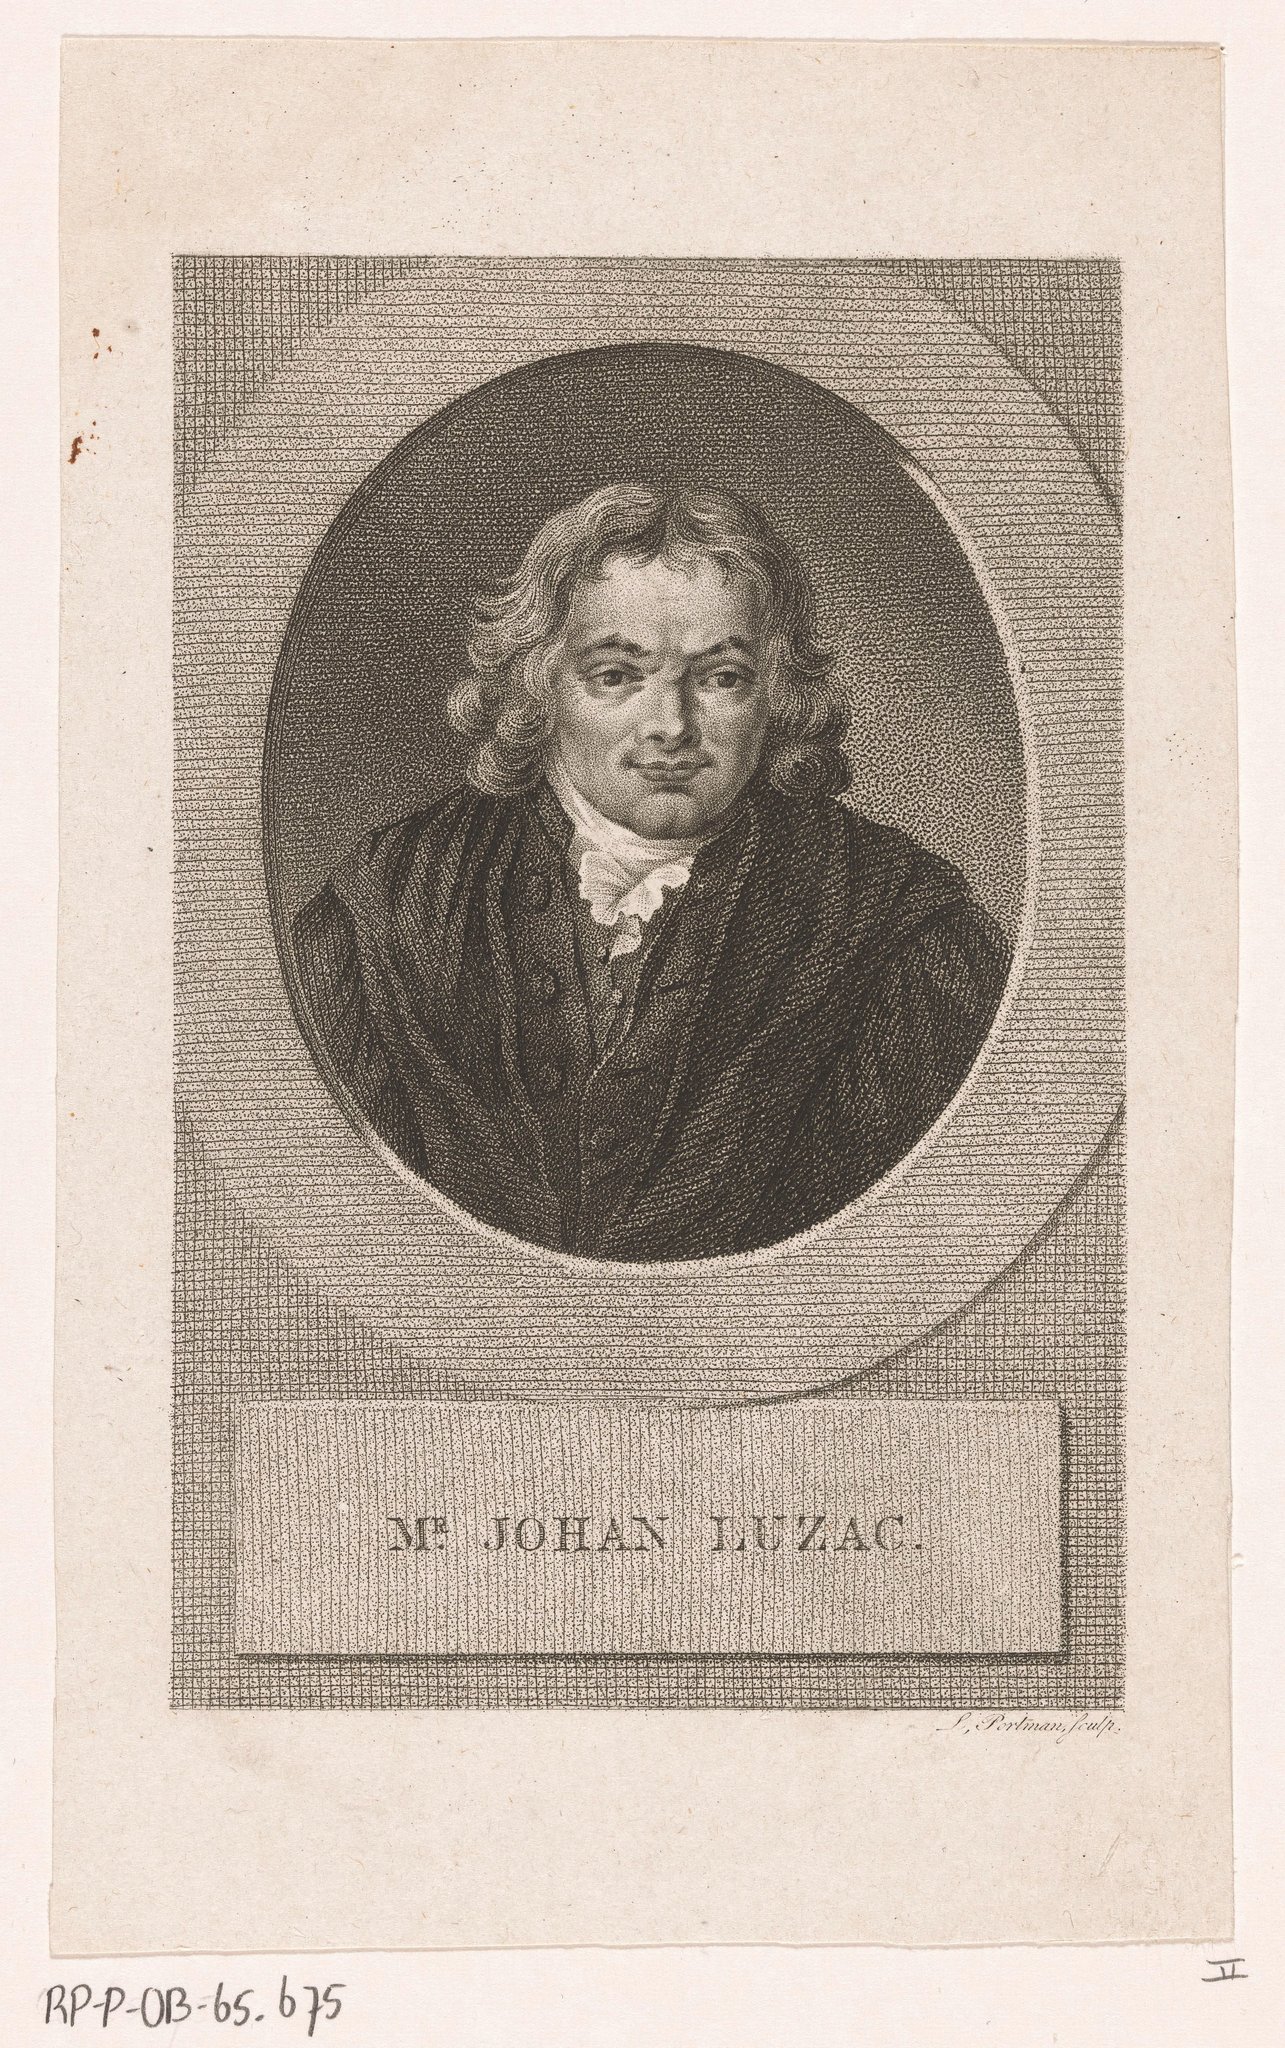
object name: print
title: Portret van hoogleraar Jean Luzac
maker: ludwig gottlieb portman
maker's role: print maker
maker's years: 1772-1828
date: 1787-1828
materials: paper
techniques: stippled etching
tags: leiden, publisher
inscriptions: collector's mark: Lugt 2228